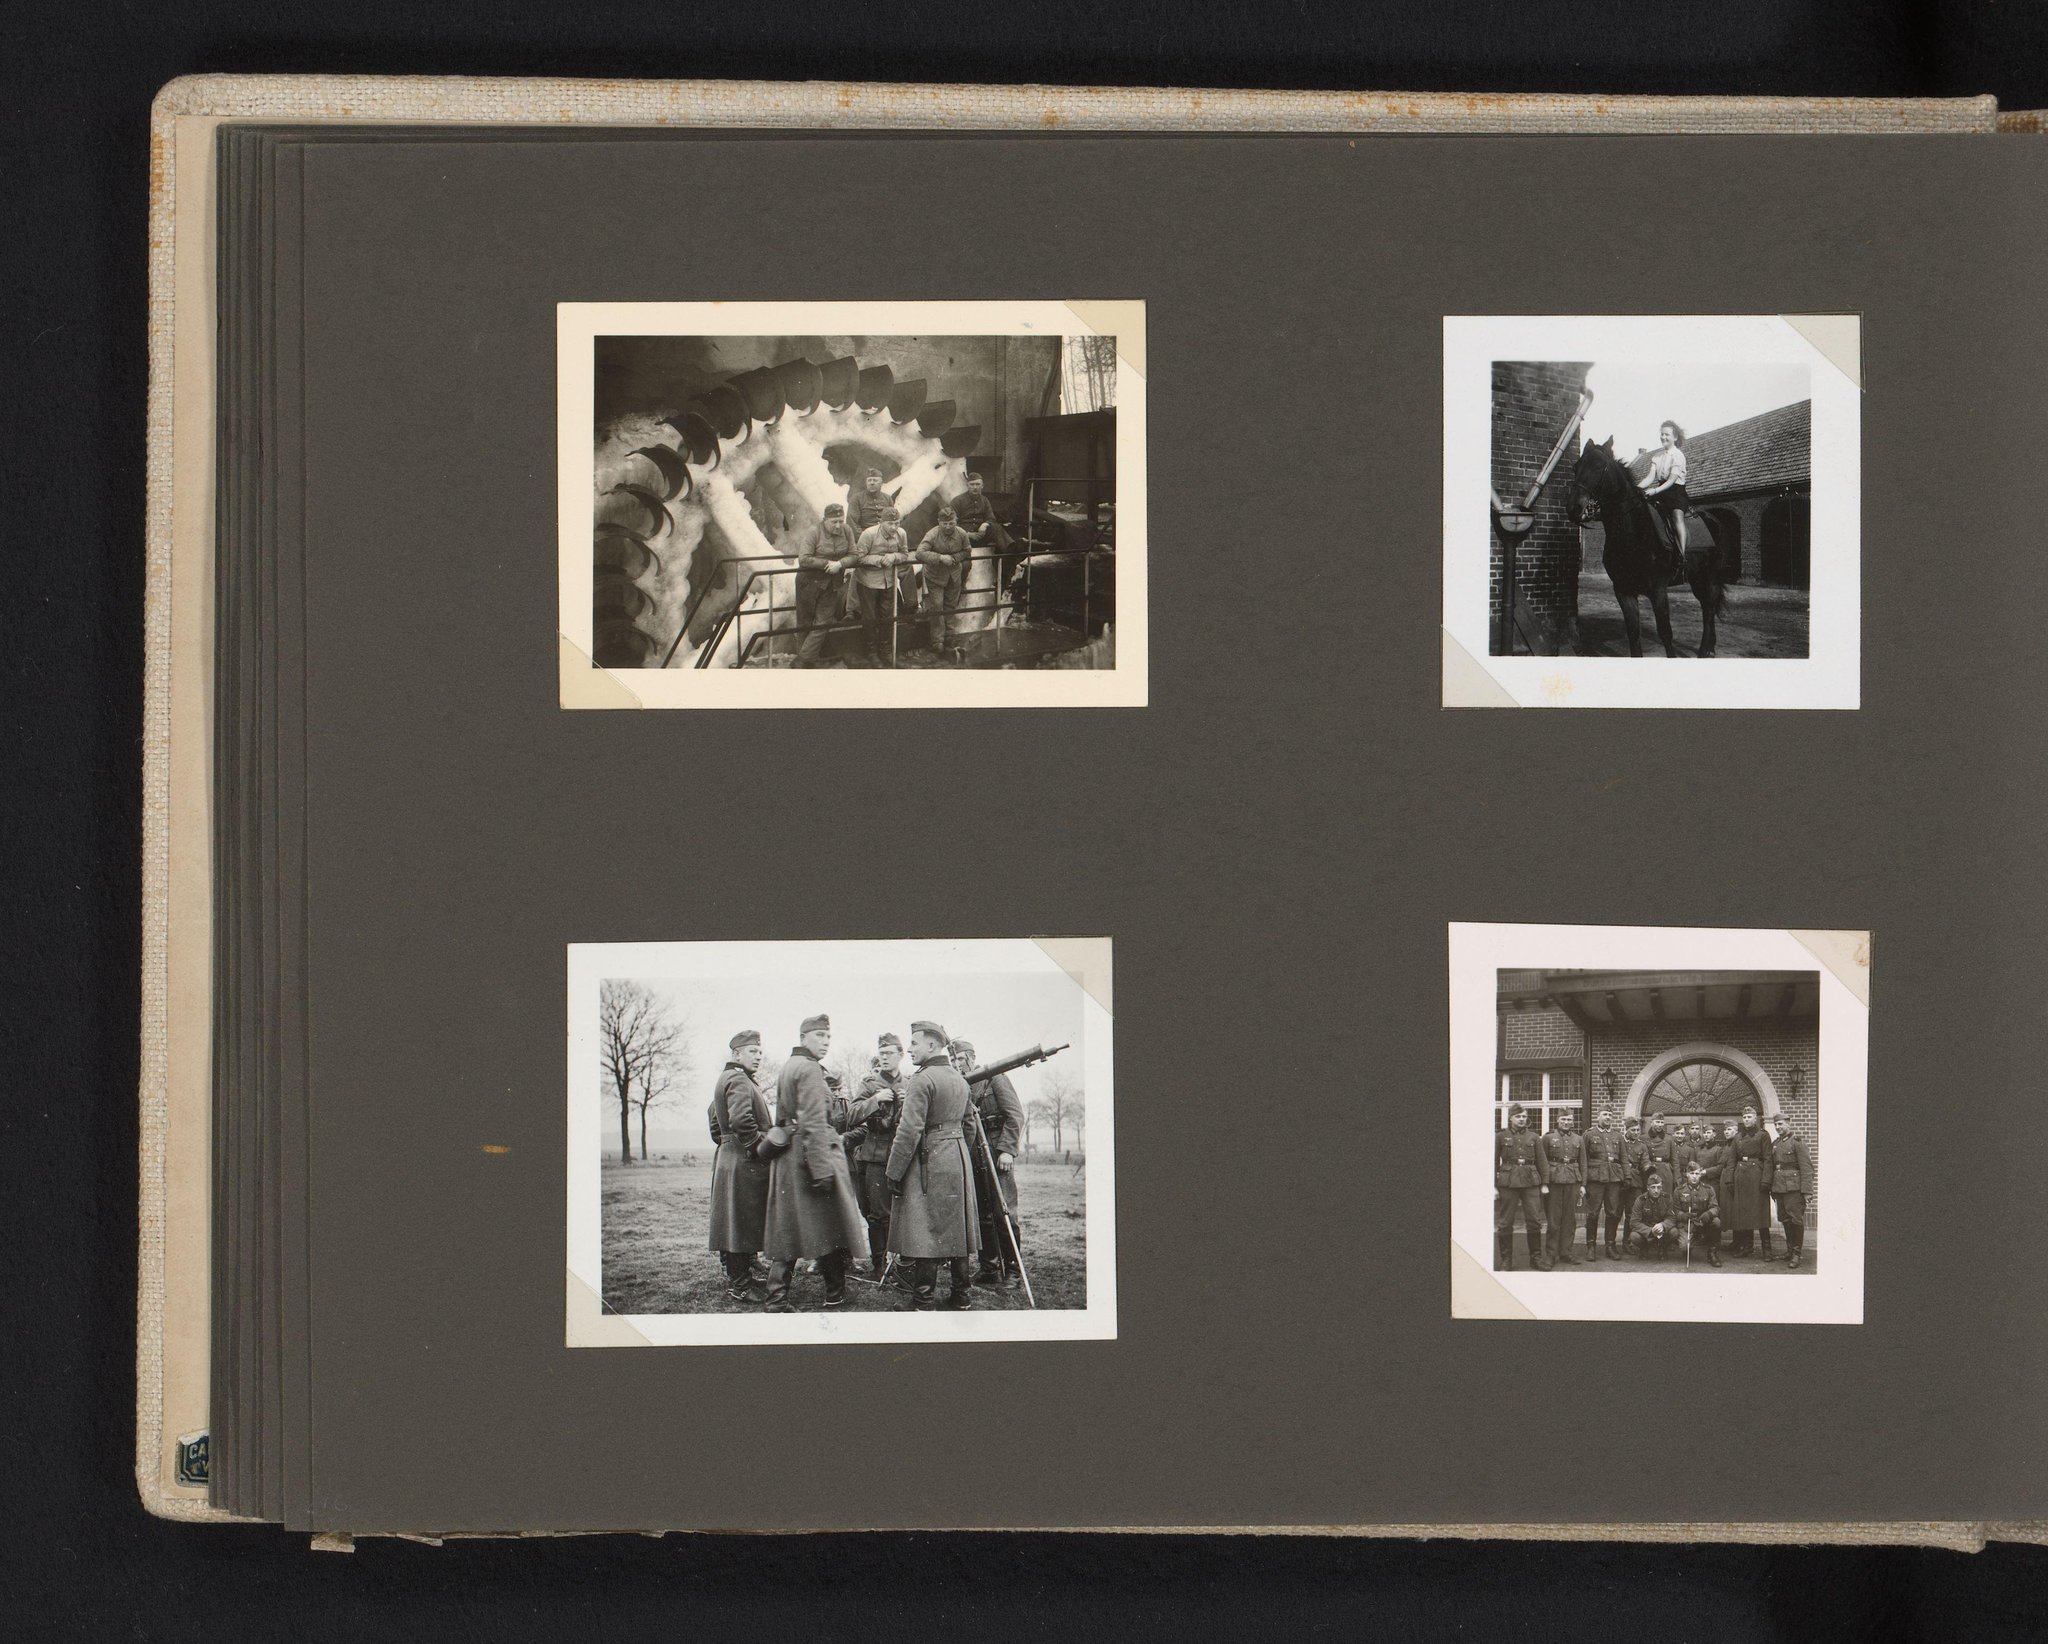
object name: album leaf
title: Groepsfoto's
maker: Anonymous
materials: cardboard, photographic support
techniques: gelatin silver print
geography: germany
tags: the company, the unit, the troop ~ military service, handling of weapons ~ military training, military training, germany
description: Albumblad met vier foto's van de militairen, o.a. bij een waterrad, rondom een stuk geschut en een foto van een jonge vrouw te paard, februari-mei 1940. Onderdeel van de fotoalbum van de Wehrmacht 1938-1941.